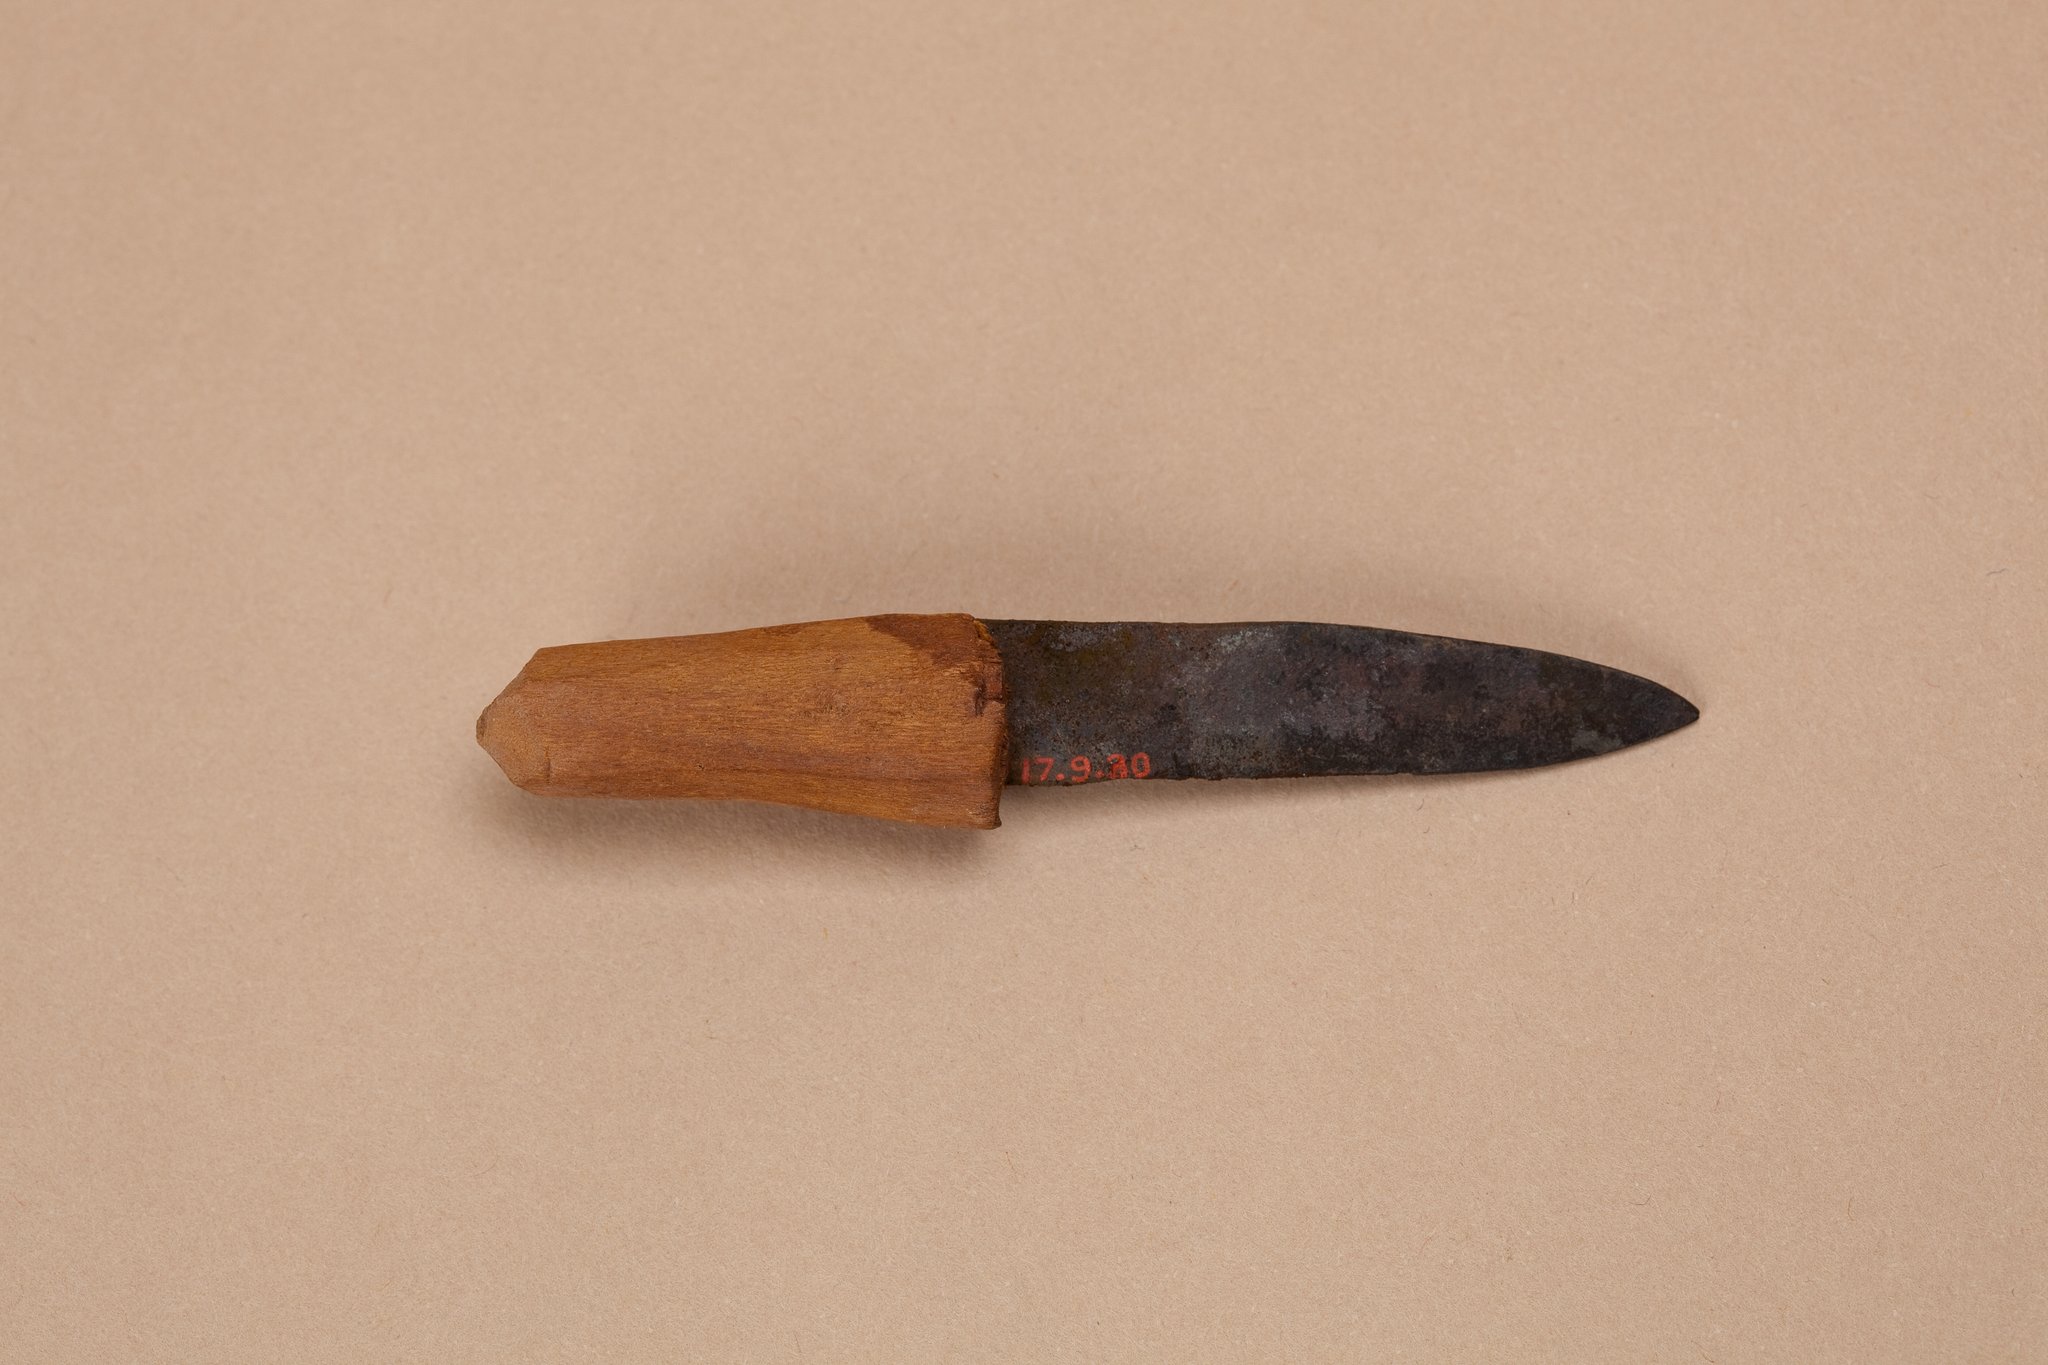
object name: model chisel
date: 1981-1802 BCE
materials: copper, wood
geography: egypt